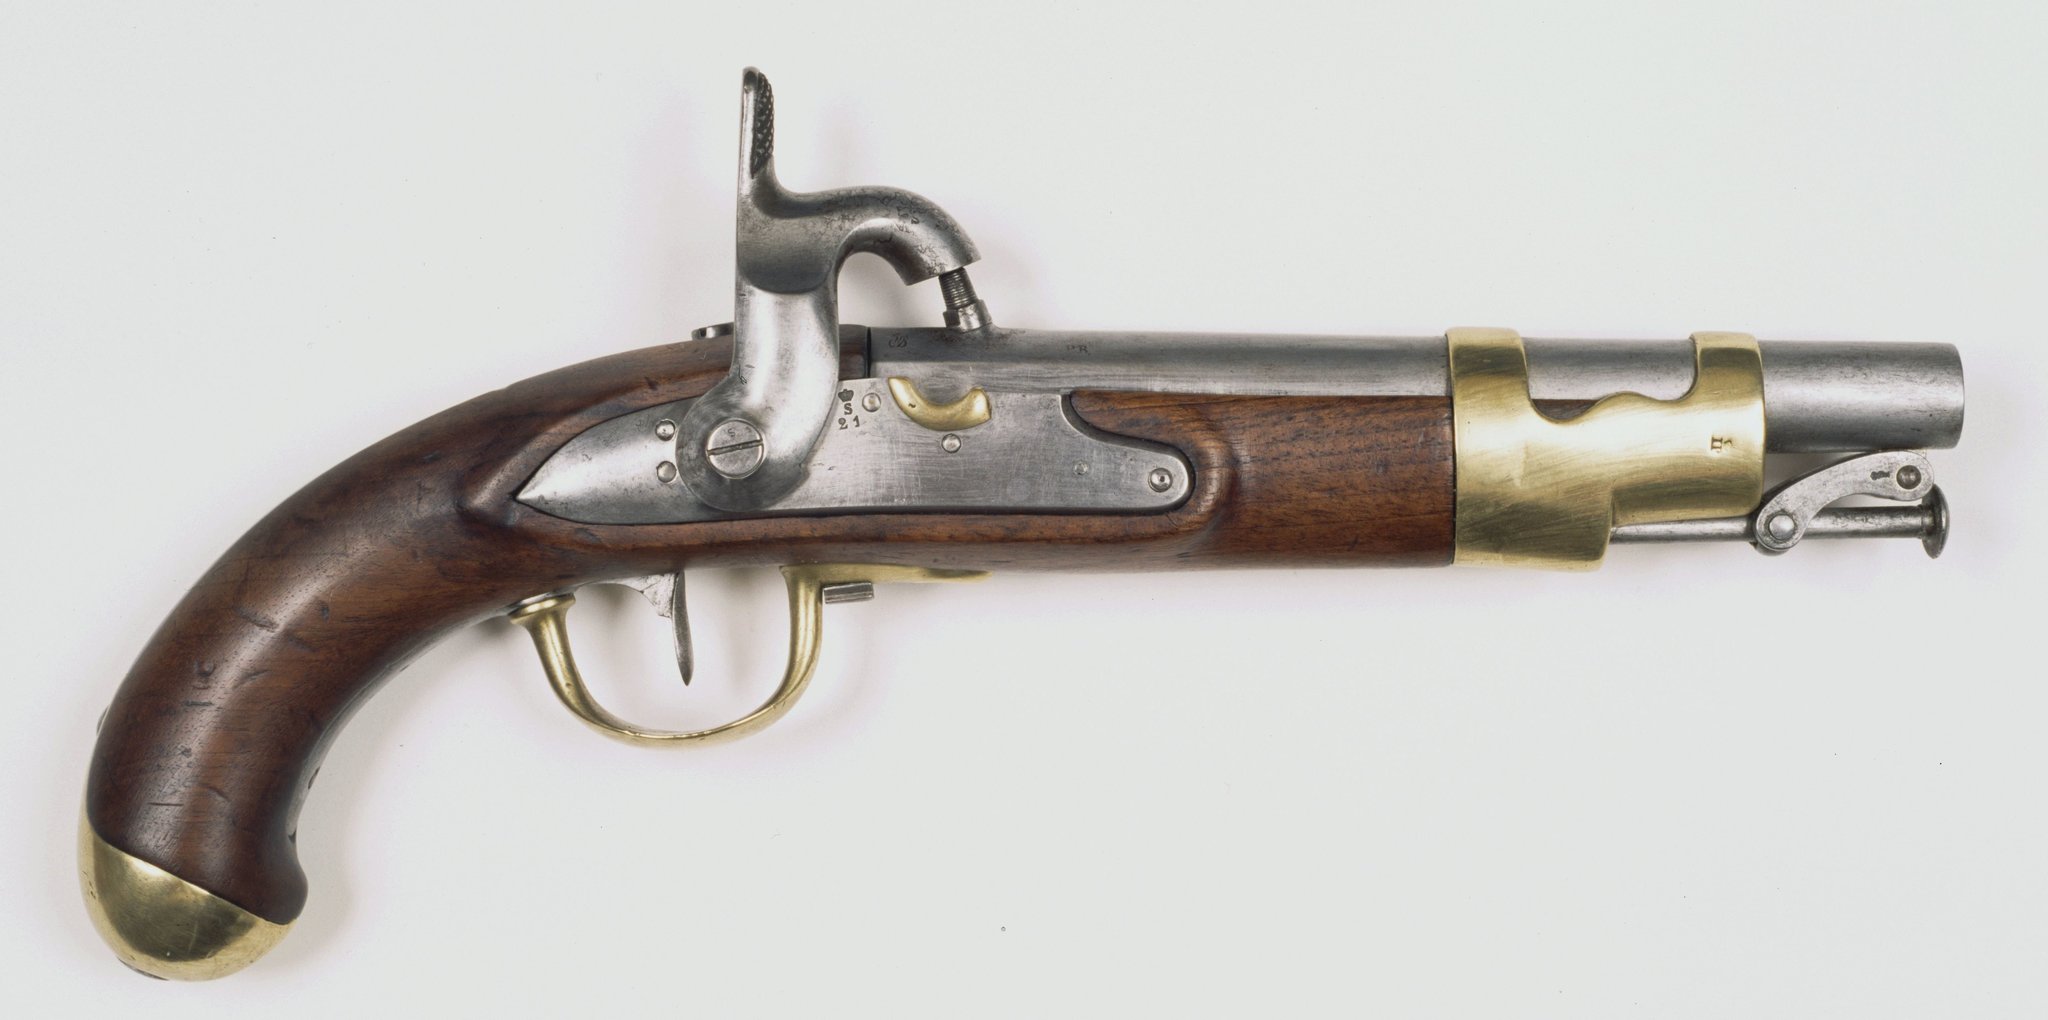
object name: percussion pistol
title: Percussie legerpistool Model 1820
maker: Anonymous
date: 1820-1821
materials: brass, iron, wood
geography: netherlands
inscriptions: mark: ‘S met kroon’, mark: ‘PB’, mark: ‘IB met kroon’, number: ‘1821’, mark, mark: ‘CD’, mark: ‘S met kroon 21’